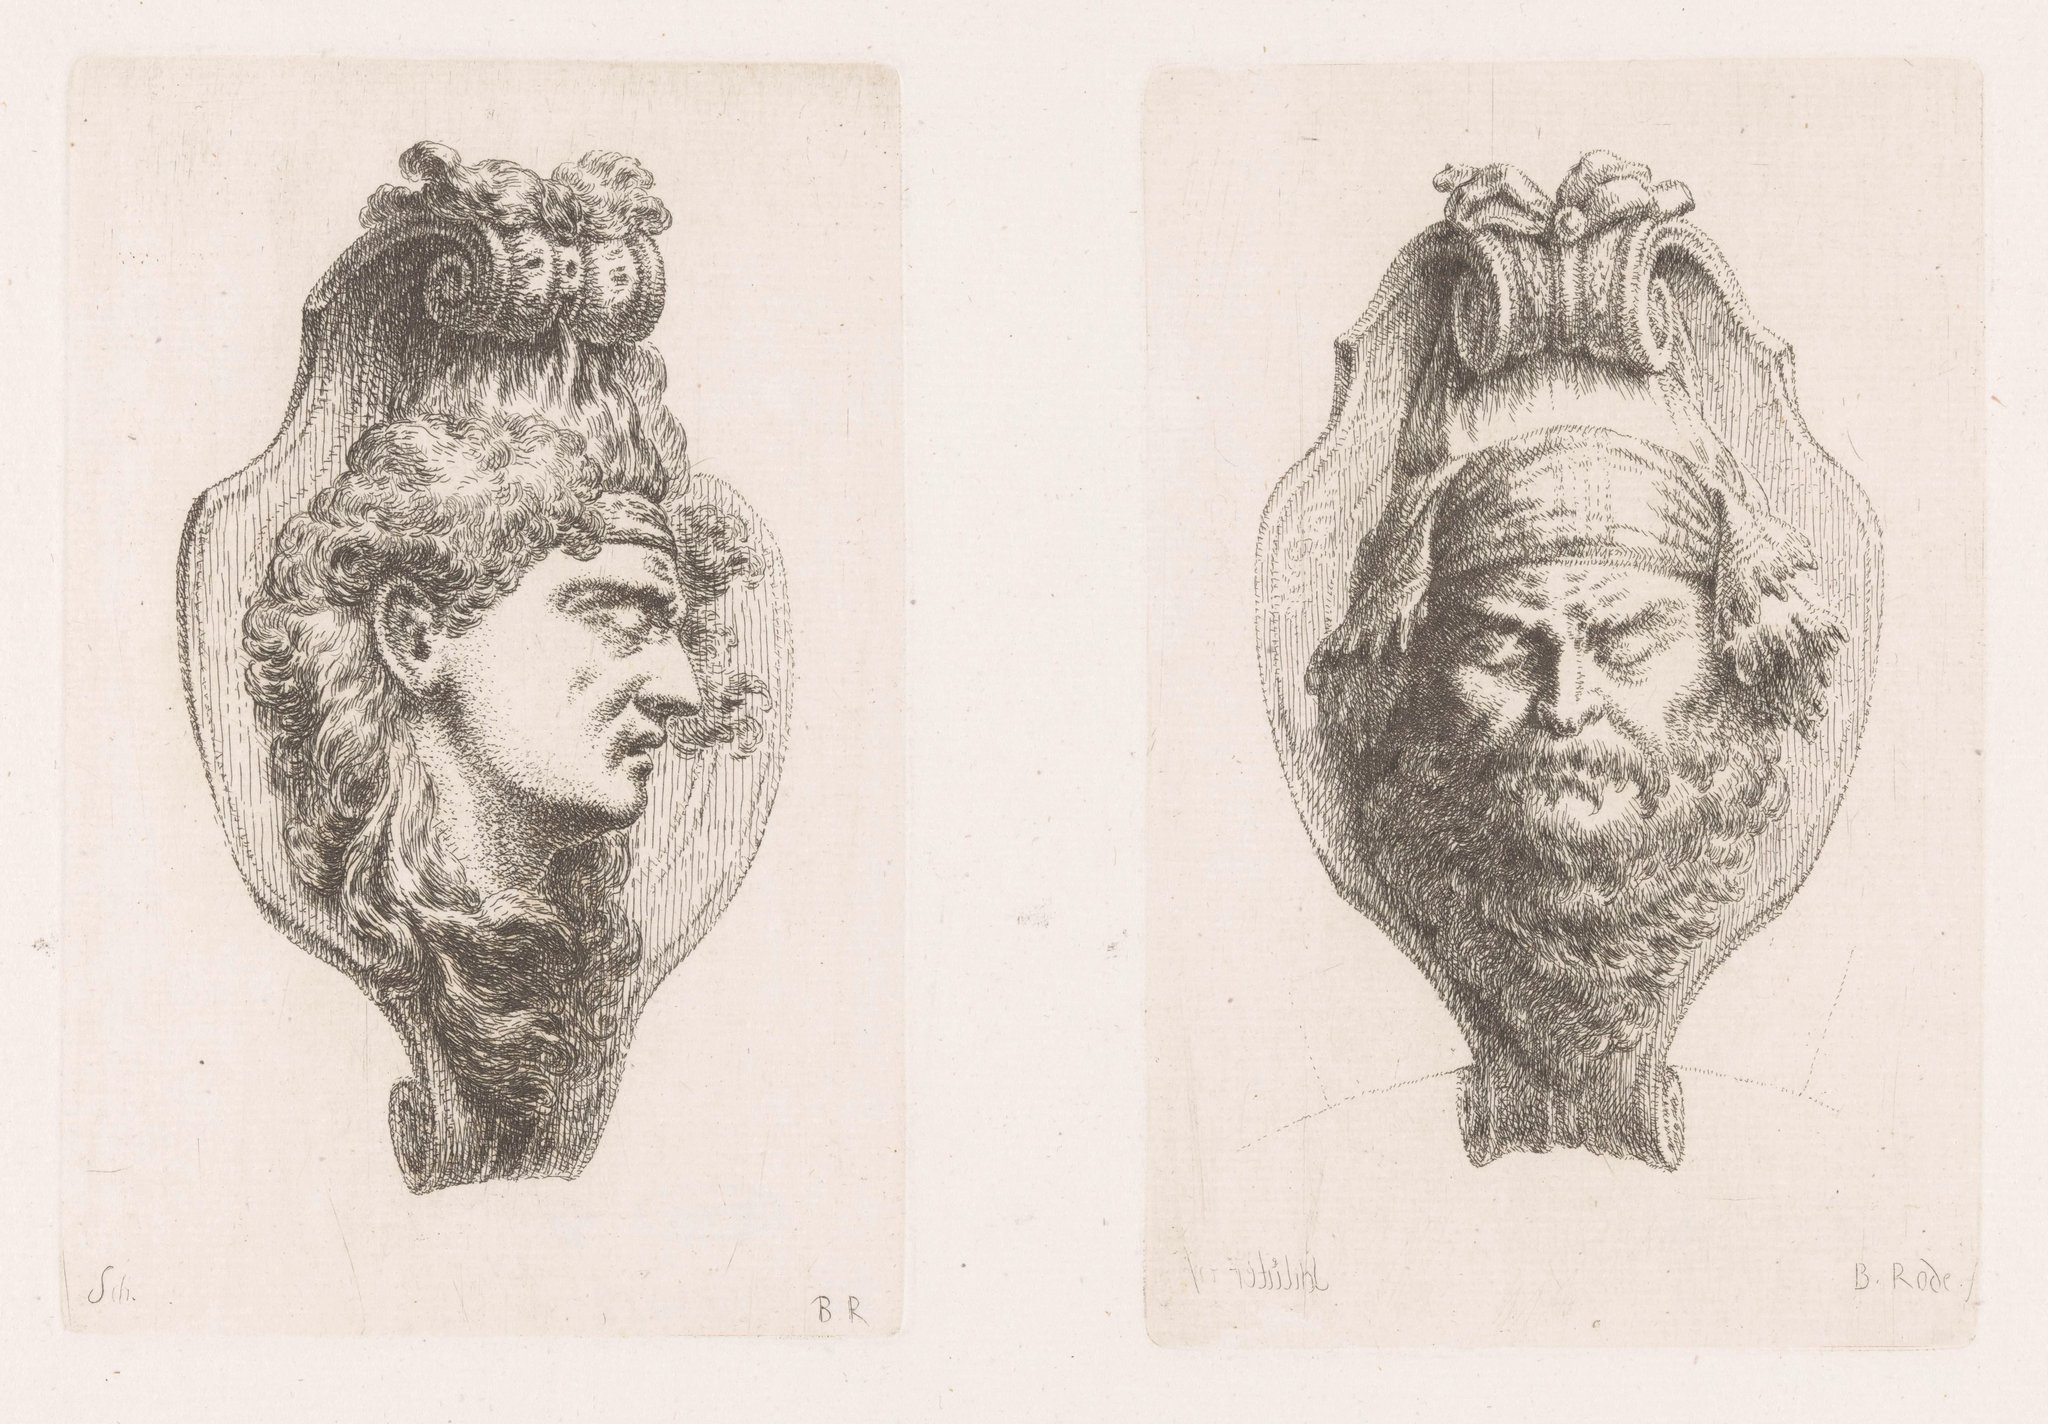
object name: ornament print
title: Jonge en oude gestorven krijger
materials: paper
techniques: etching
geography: berlin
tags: mask, mascaron ~ ornament, the soldier; the soldier's life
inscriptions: collector's mark: Lugt 2760, collector's mark: Lugt 2228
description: Prent is gemaakt naar de sculpturen van Andreas Schlüter in het Zeughaus (tegenwoordig het Deutsches Historisches Museum) te Berlijn. Mogelijk prent uit: Rode, Bernhard. Larven nach den Modelen des berühmten Schlüters gezeichnet und in Kupfer geätzt von B. Rode. Berlijn: Rode, Heinrich, 1759.